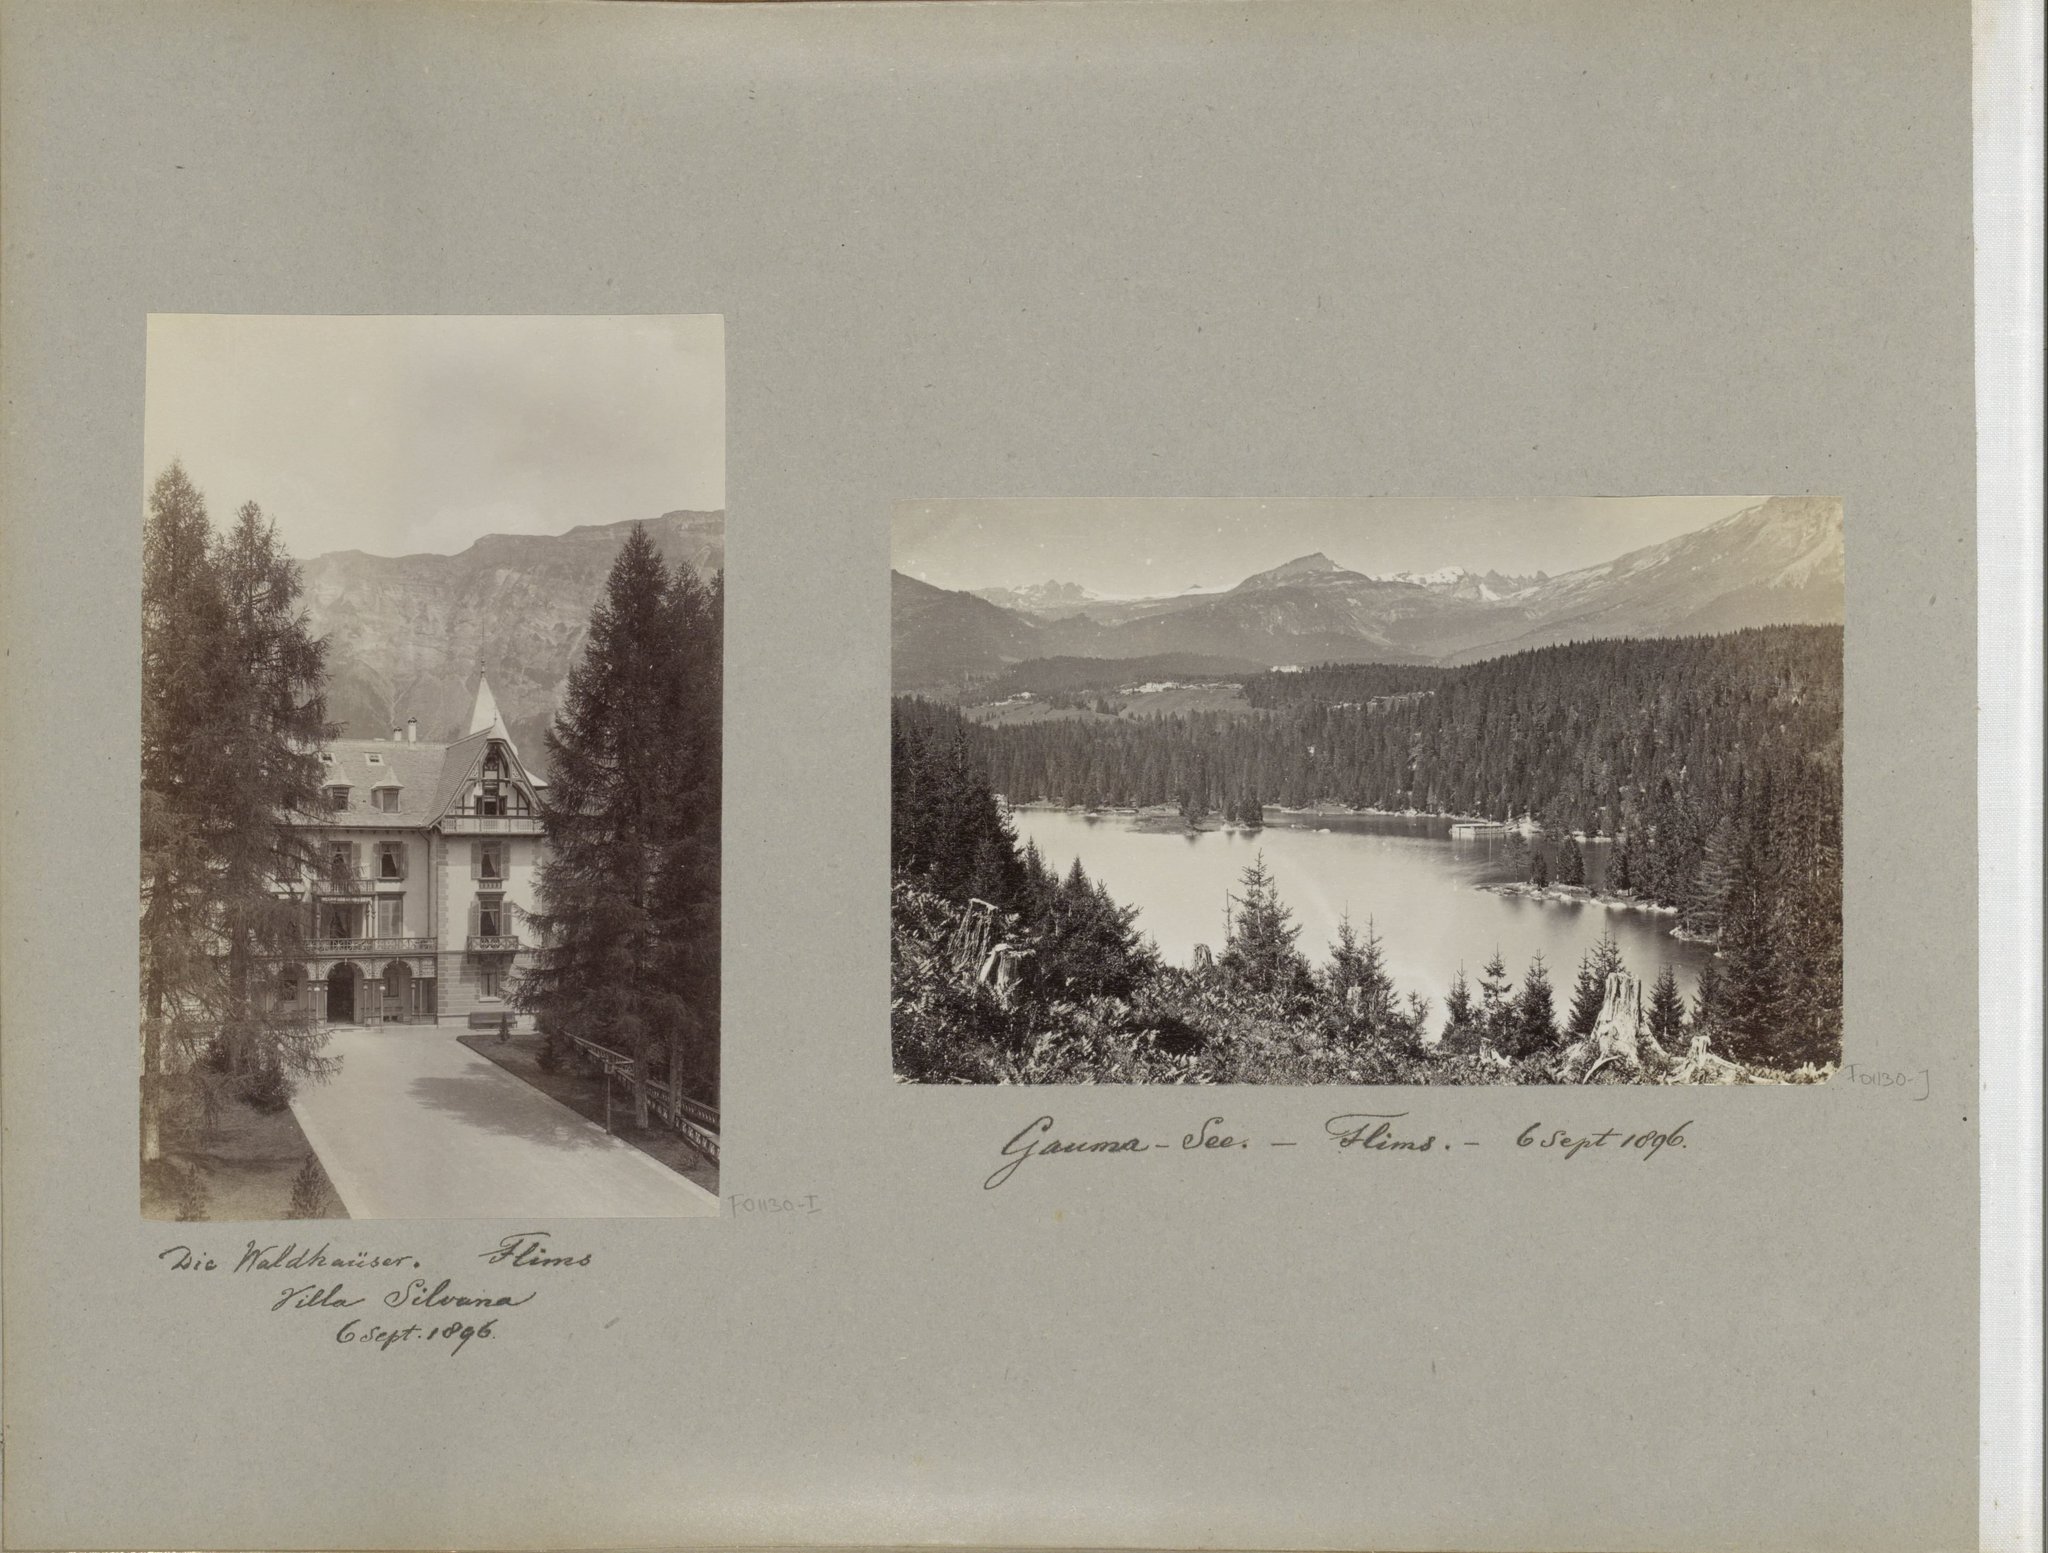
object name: album leaf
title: Gezicht op het Caumameer bij Flims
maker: Anonymous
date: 1880-1896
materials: paper, photographic support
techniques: albumen print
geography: flims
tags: lake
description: Onderdeel van Reisalbum met foto's van bezienswaardigheden in Frankrijk, Spanje, Italië, Duitsland, Zwitserland en Oostenrijk.